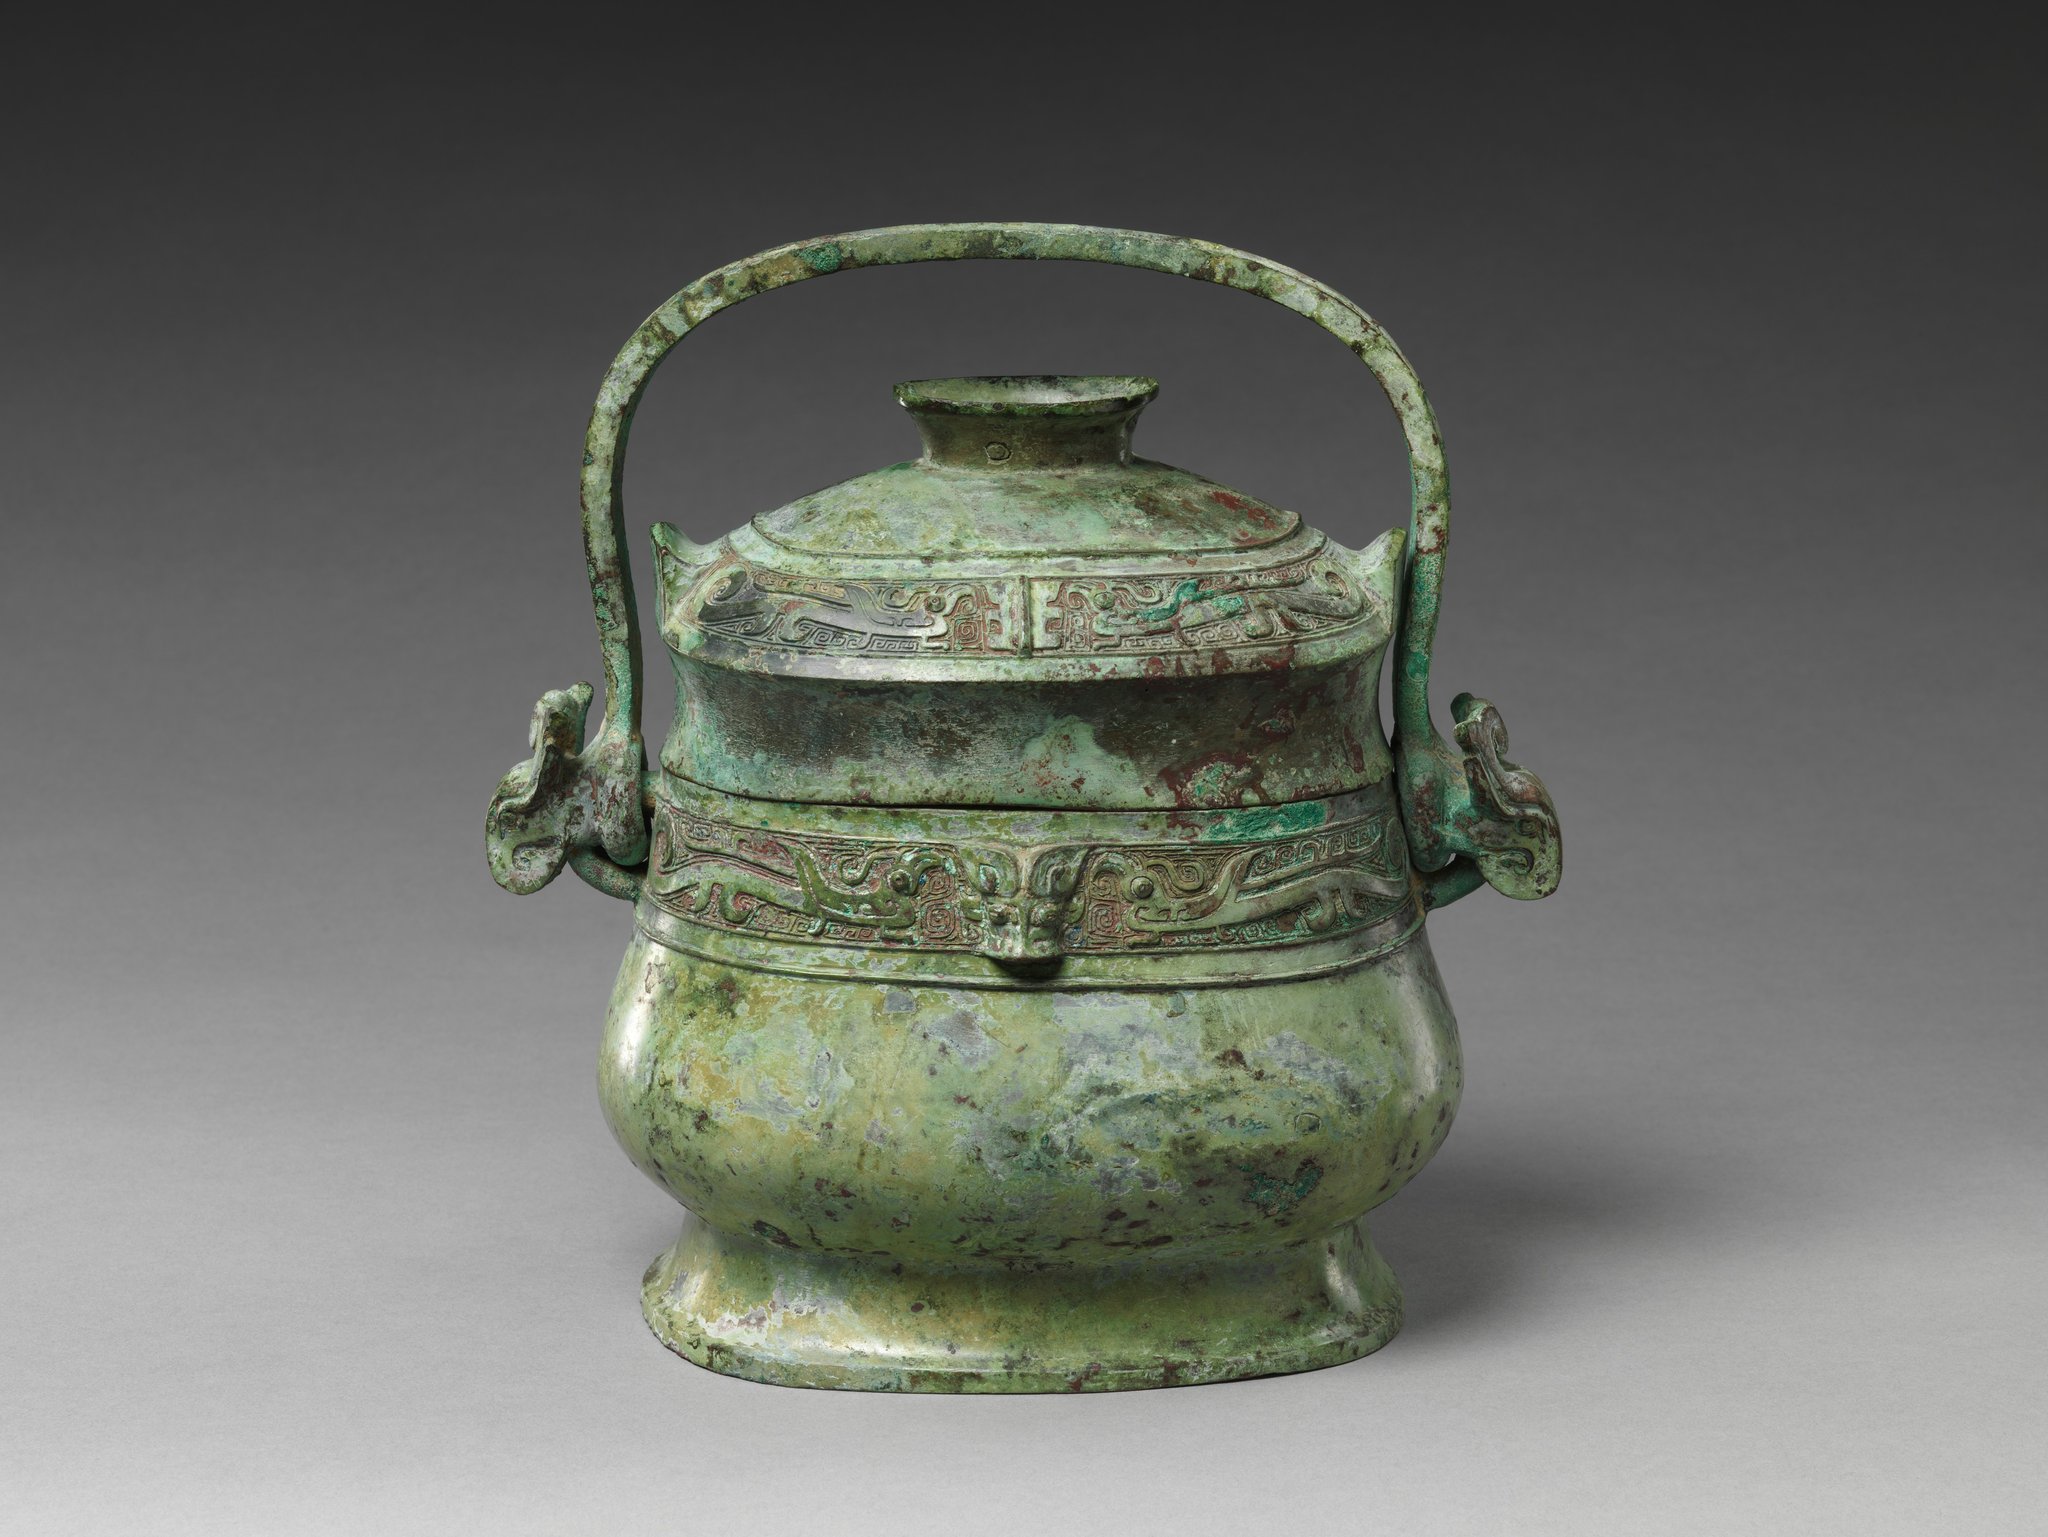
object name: wine container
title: Wine container with handle (you)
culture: chinese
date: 1000-901 BCE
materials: bronze